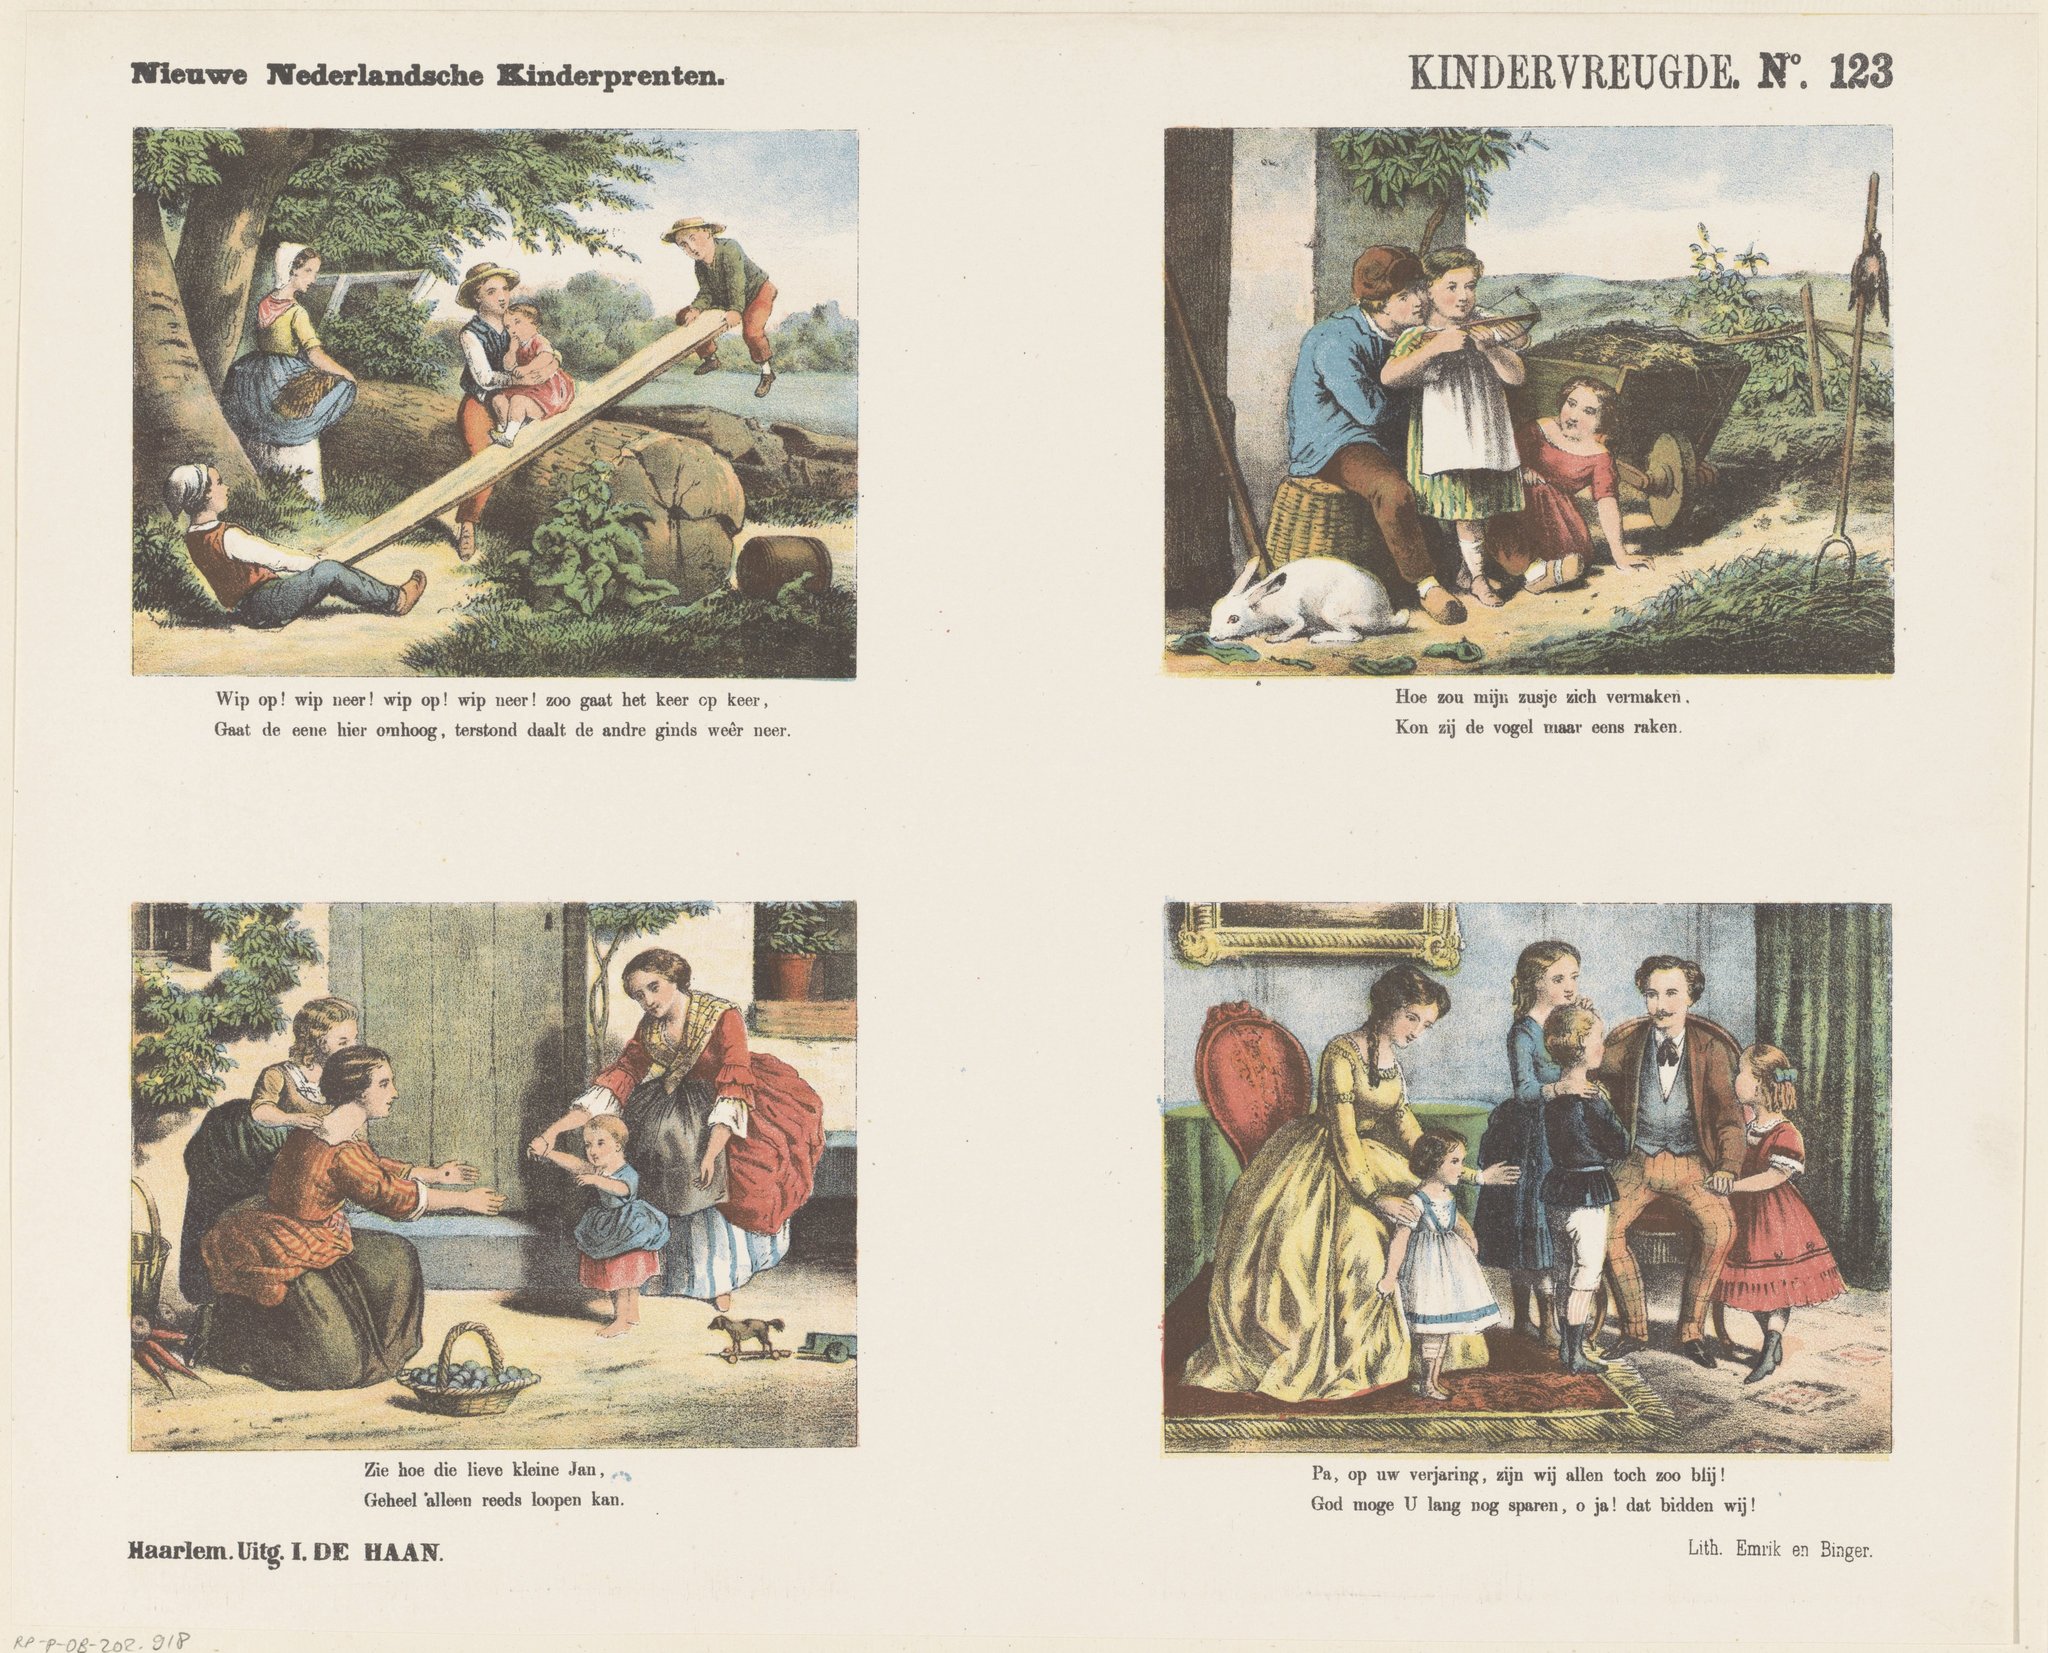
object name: print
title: Nieuwe Nederlandsche kinderprenten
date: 1875-1903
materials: paper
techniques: lithograph, letterpress printing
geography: haarlem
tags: children's games and plays, child, shooting with bow and arrow, archery (~ games of skill), learning to walk, the first steps, seesaw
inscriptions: collector's mark: Lugt 2760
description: Blad met 4 voorstellingen van kindertaferelen, bijvoorbeeld kinderen die wippen en boogschieten. Onder elke voorstelling een tweeregelig vers. Genummerd rechtsboven: No. 123.